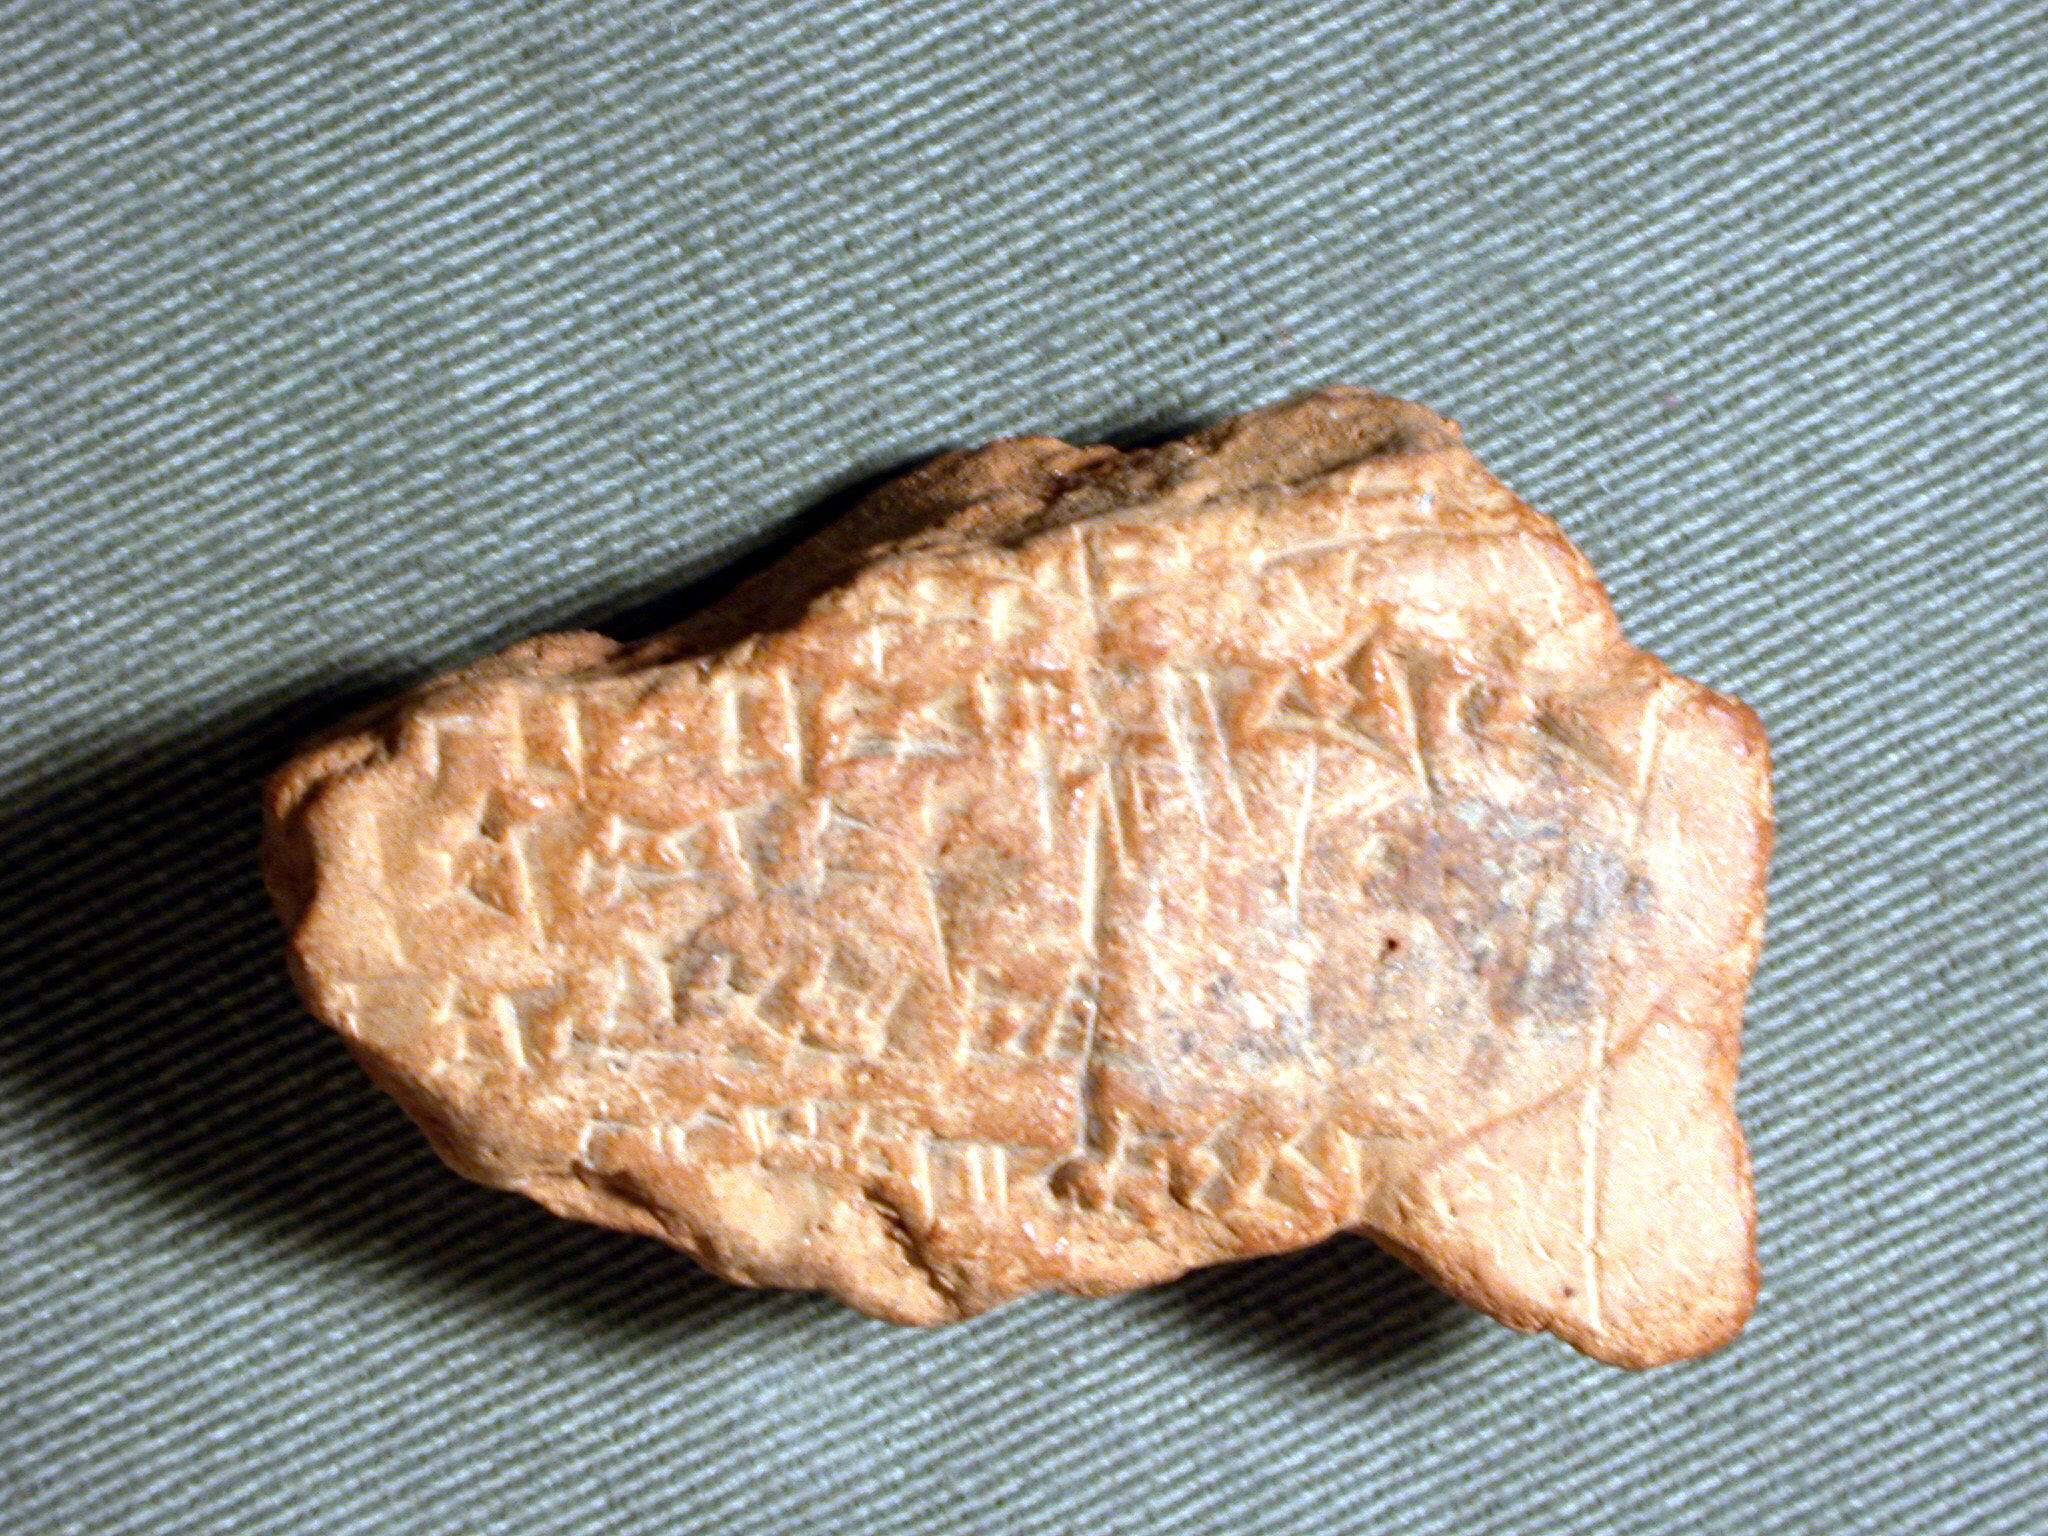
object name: cuneiform tablet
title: Cuneiform tablet: fragment, content uncertain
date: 333-1 BCE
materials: clay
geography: mesopotamia